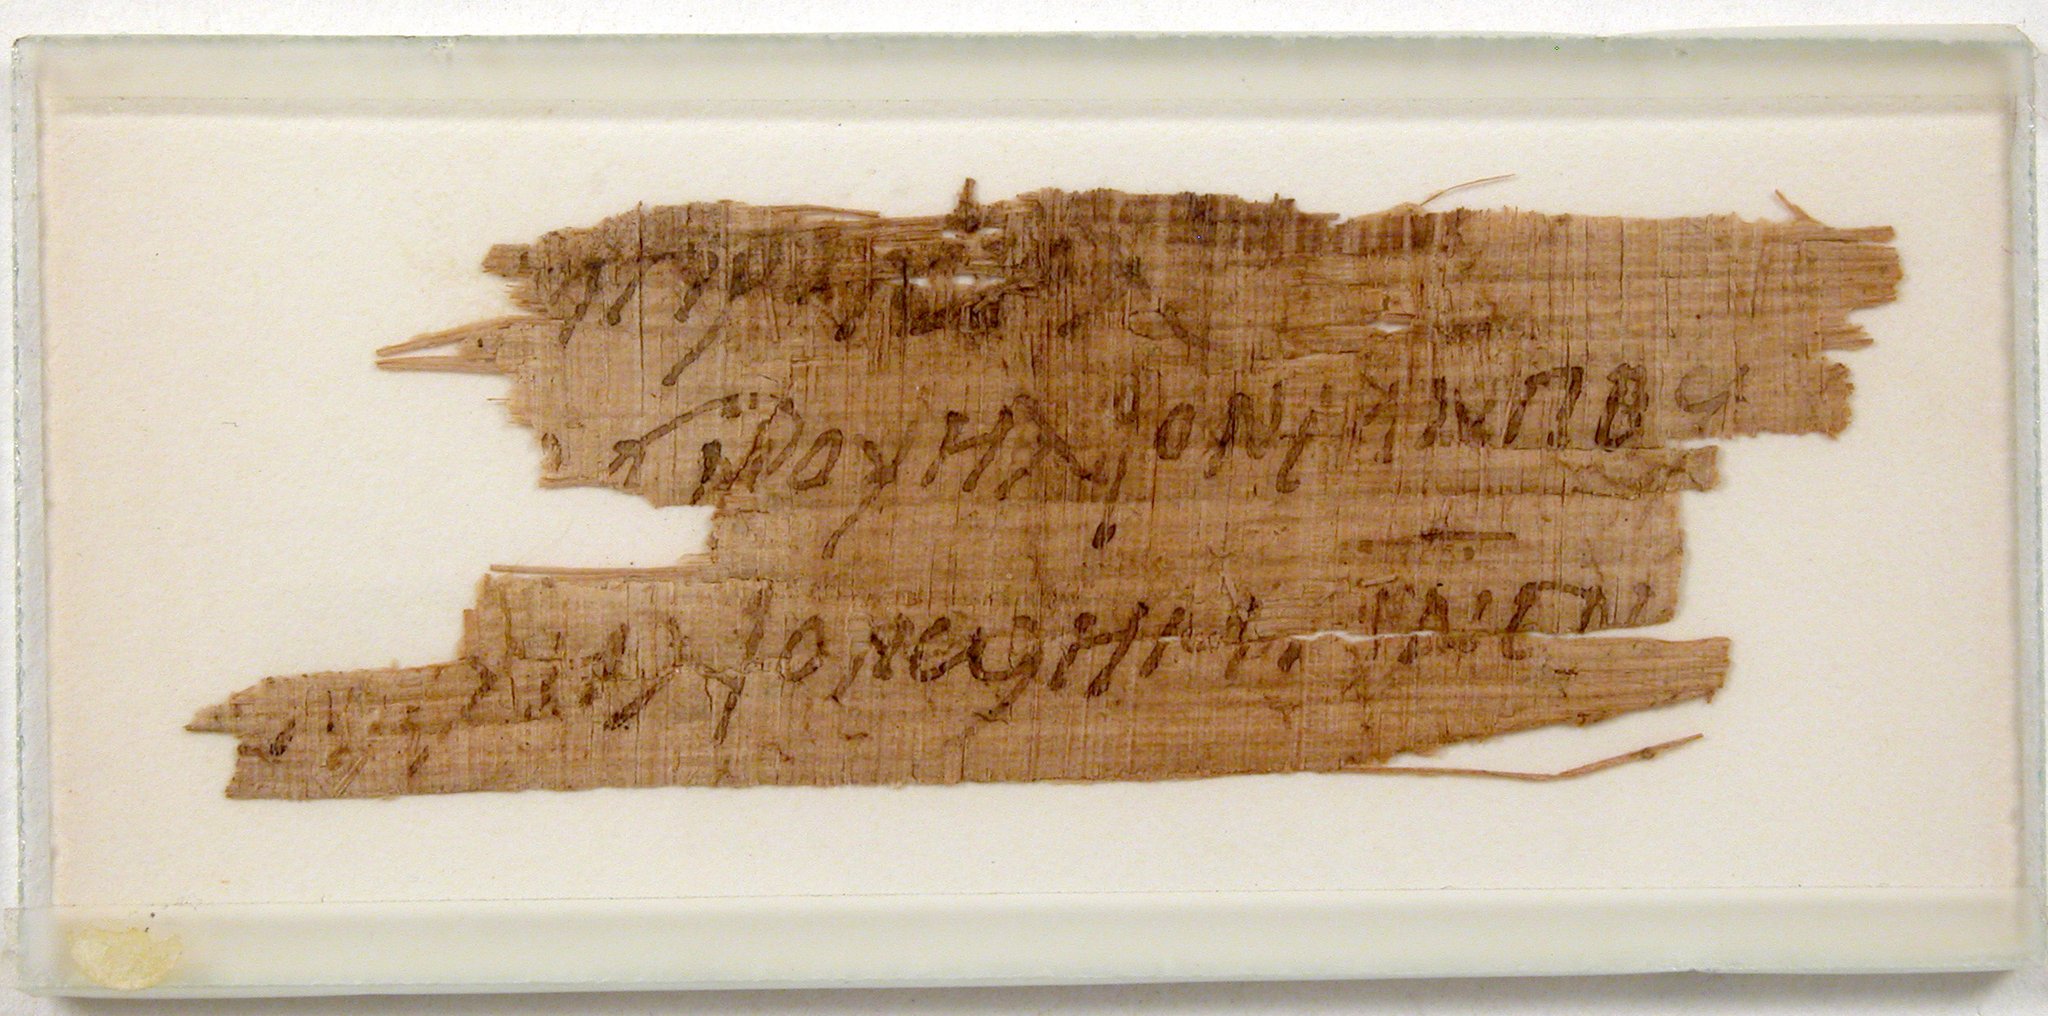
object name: fragment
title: Papyrus Fragment of a List of Furniture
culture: coptic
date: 601-700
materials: ink, papyrus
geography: egypt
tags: coptic,documents